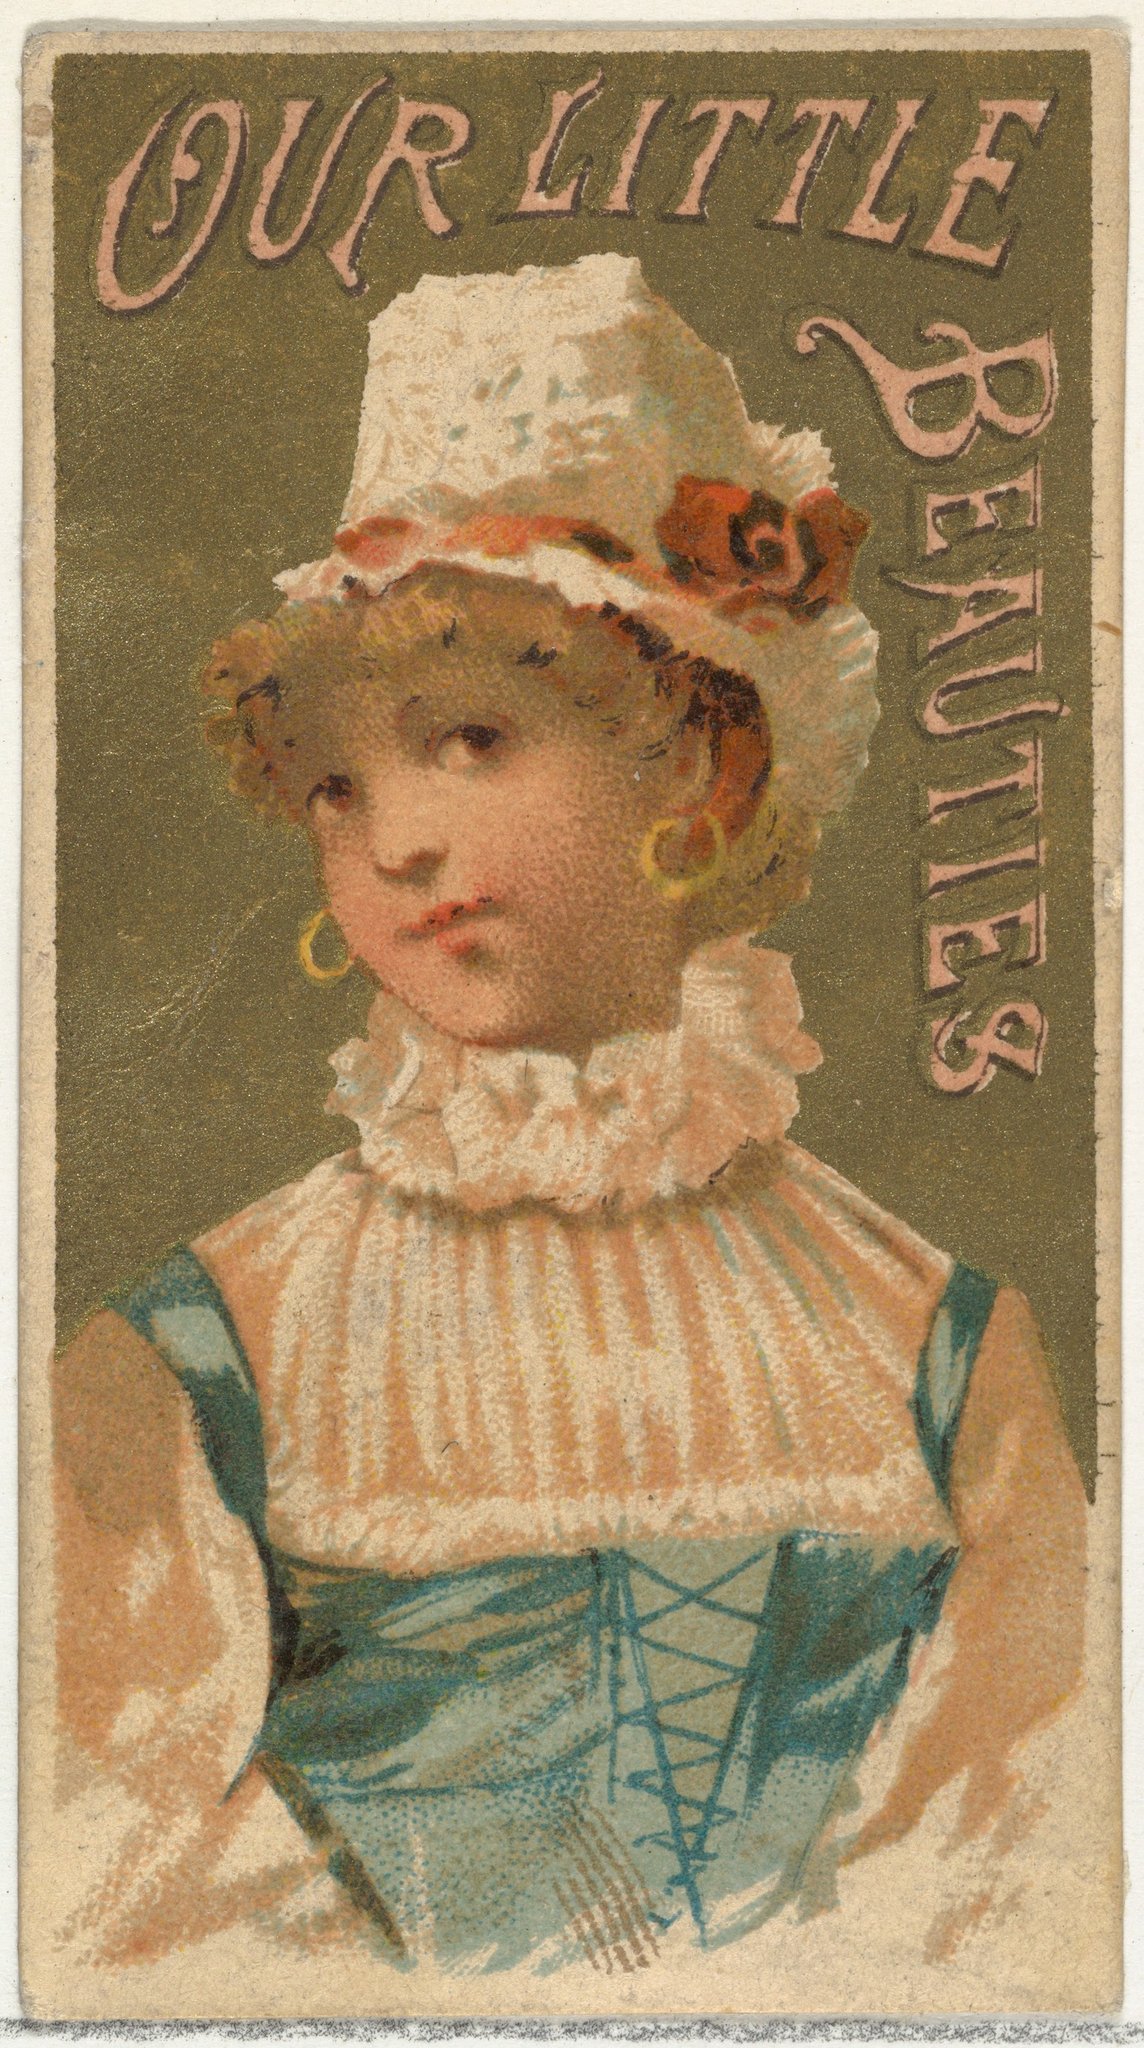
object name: print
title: From the Girls and Children series (N58) promoting Our Little Beauties Cigarettes for Allen & Ginter brand tobacco products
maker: allen & ginter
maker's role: publisher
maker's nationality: american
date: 1887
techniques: color lithograph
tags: girls